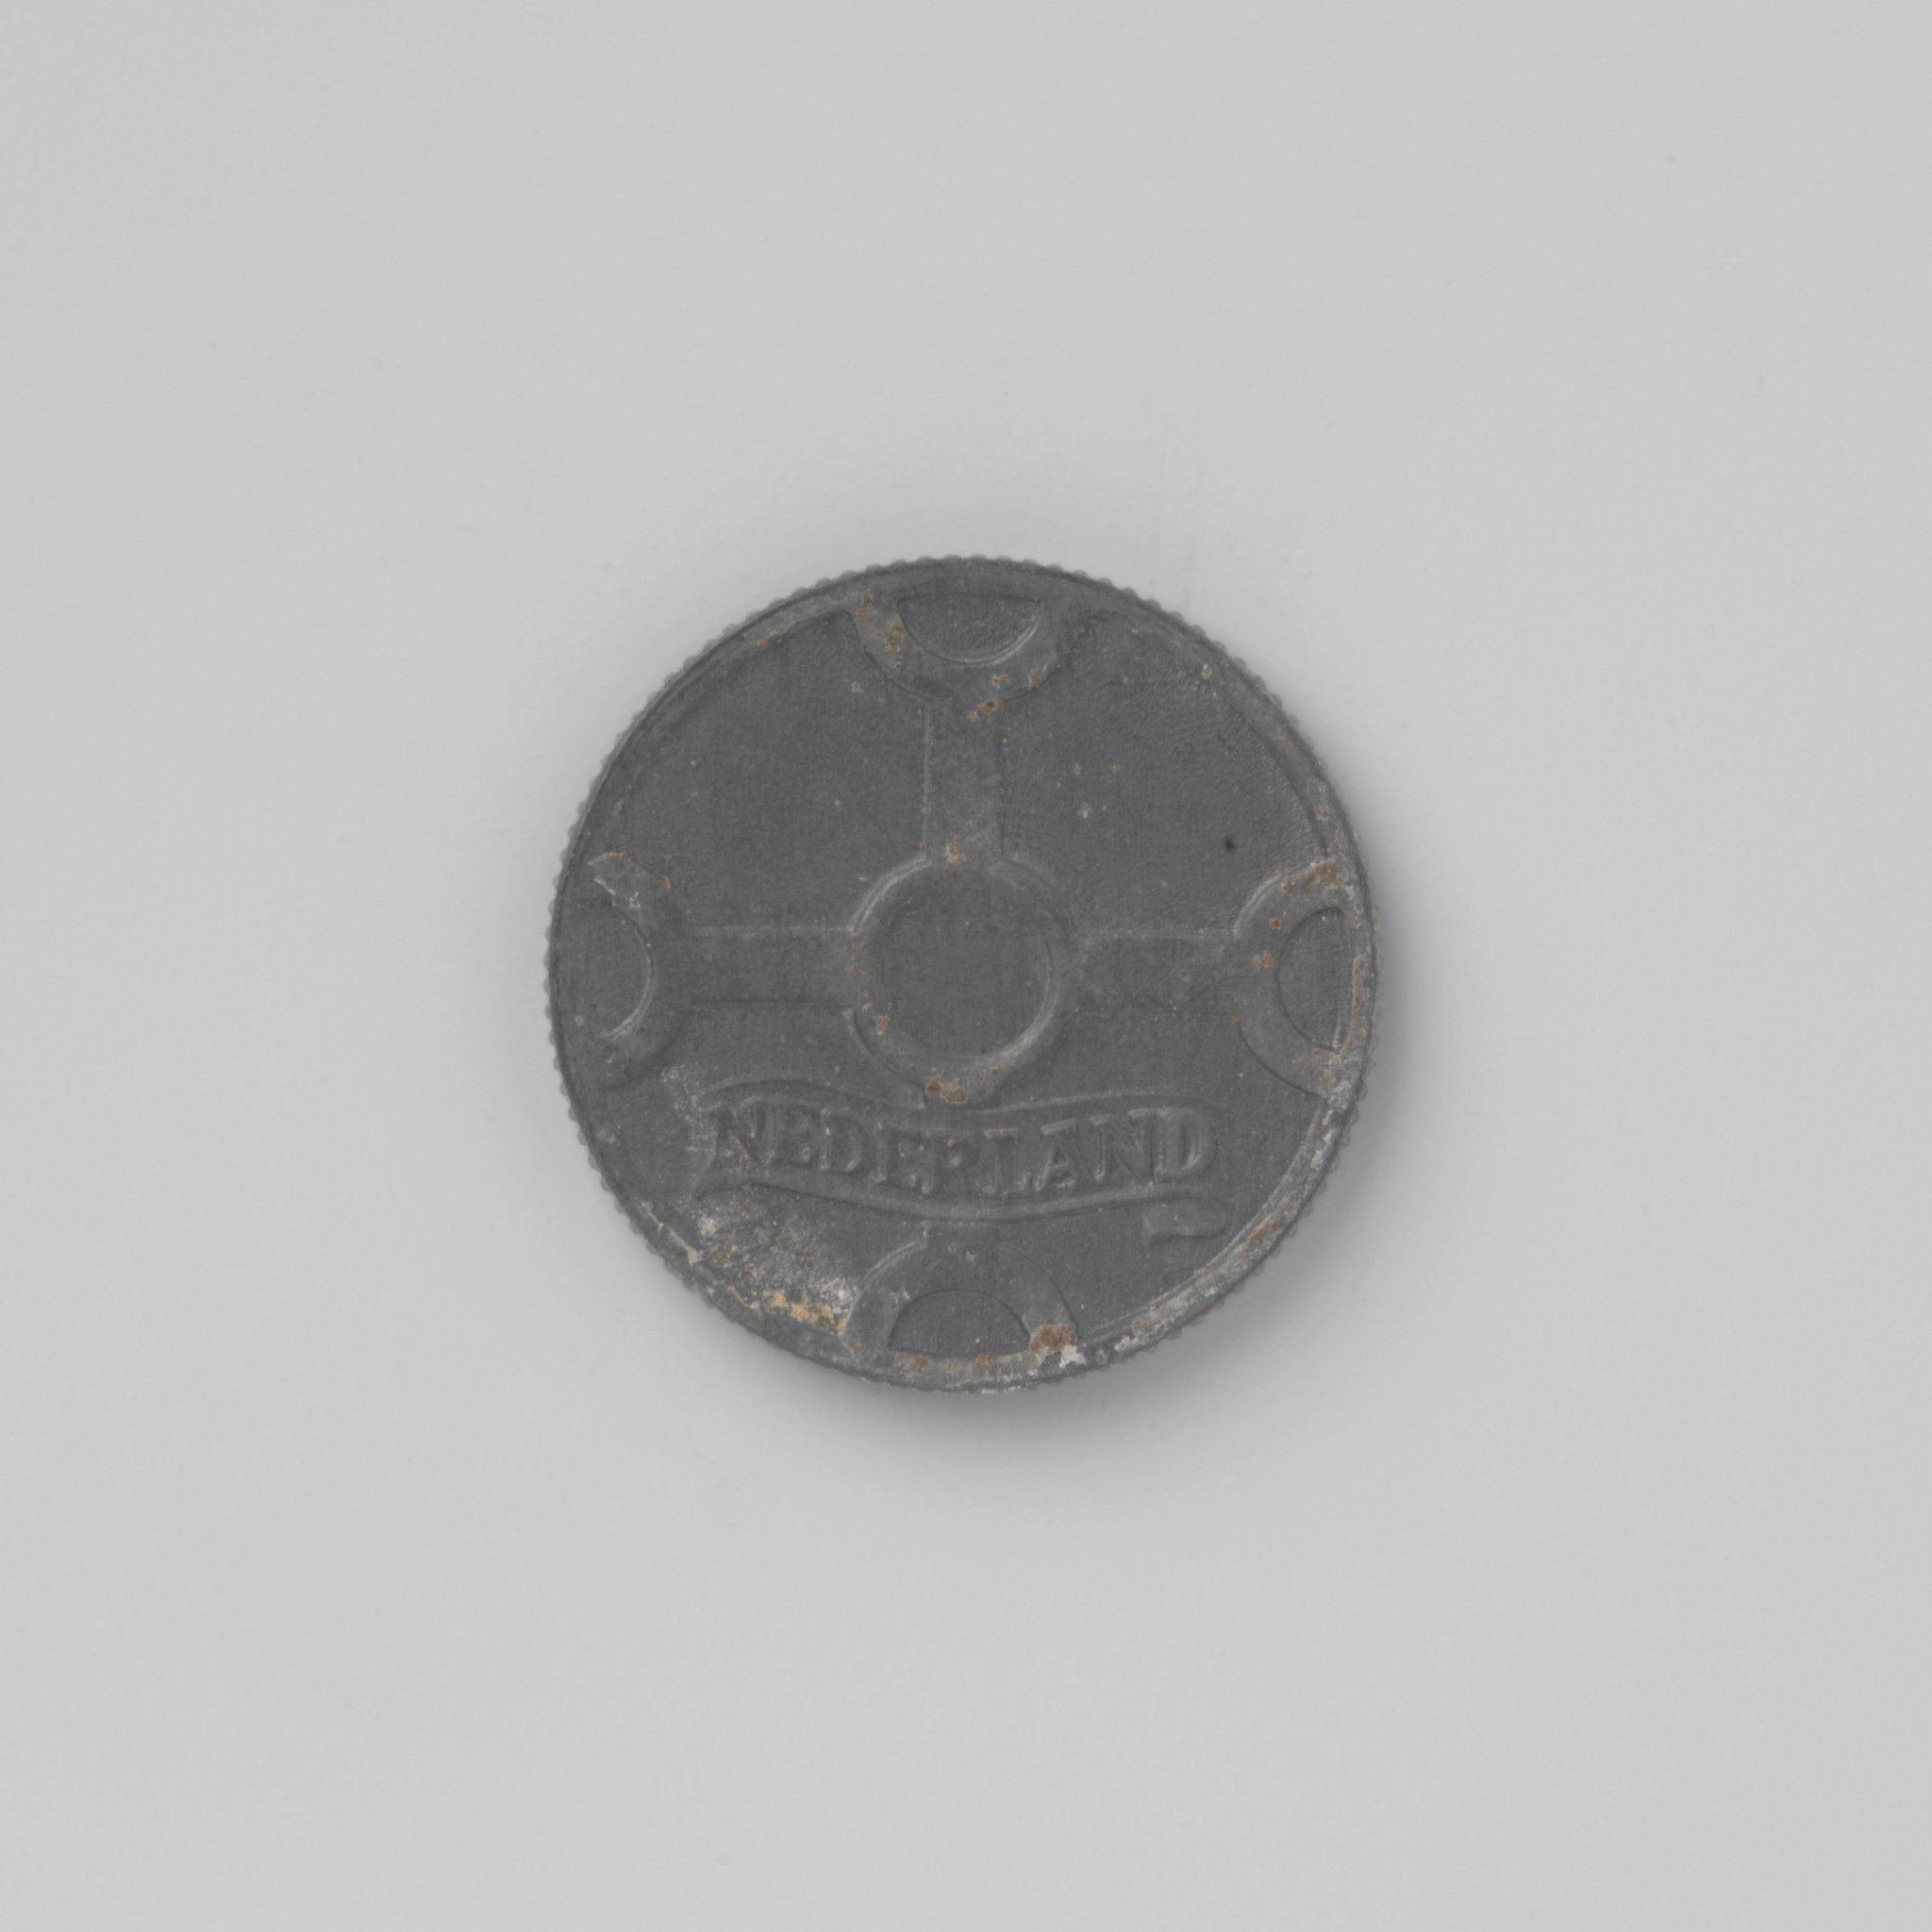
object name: coin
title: Nederlandse cent,1942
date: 1942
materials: zinc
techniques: striking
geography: utrecht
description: Zinken munt. Voorzijde: rechtkruis. Keerzijde: waarde-aanduiding 1 ct, rechts vier golven en een korenaar. daaronder op een band jaartal. Kartelrand.